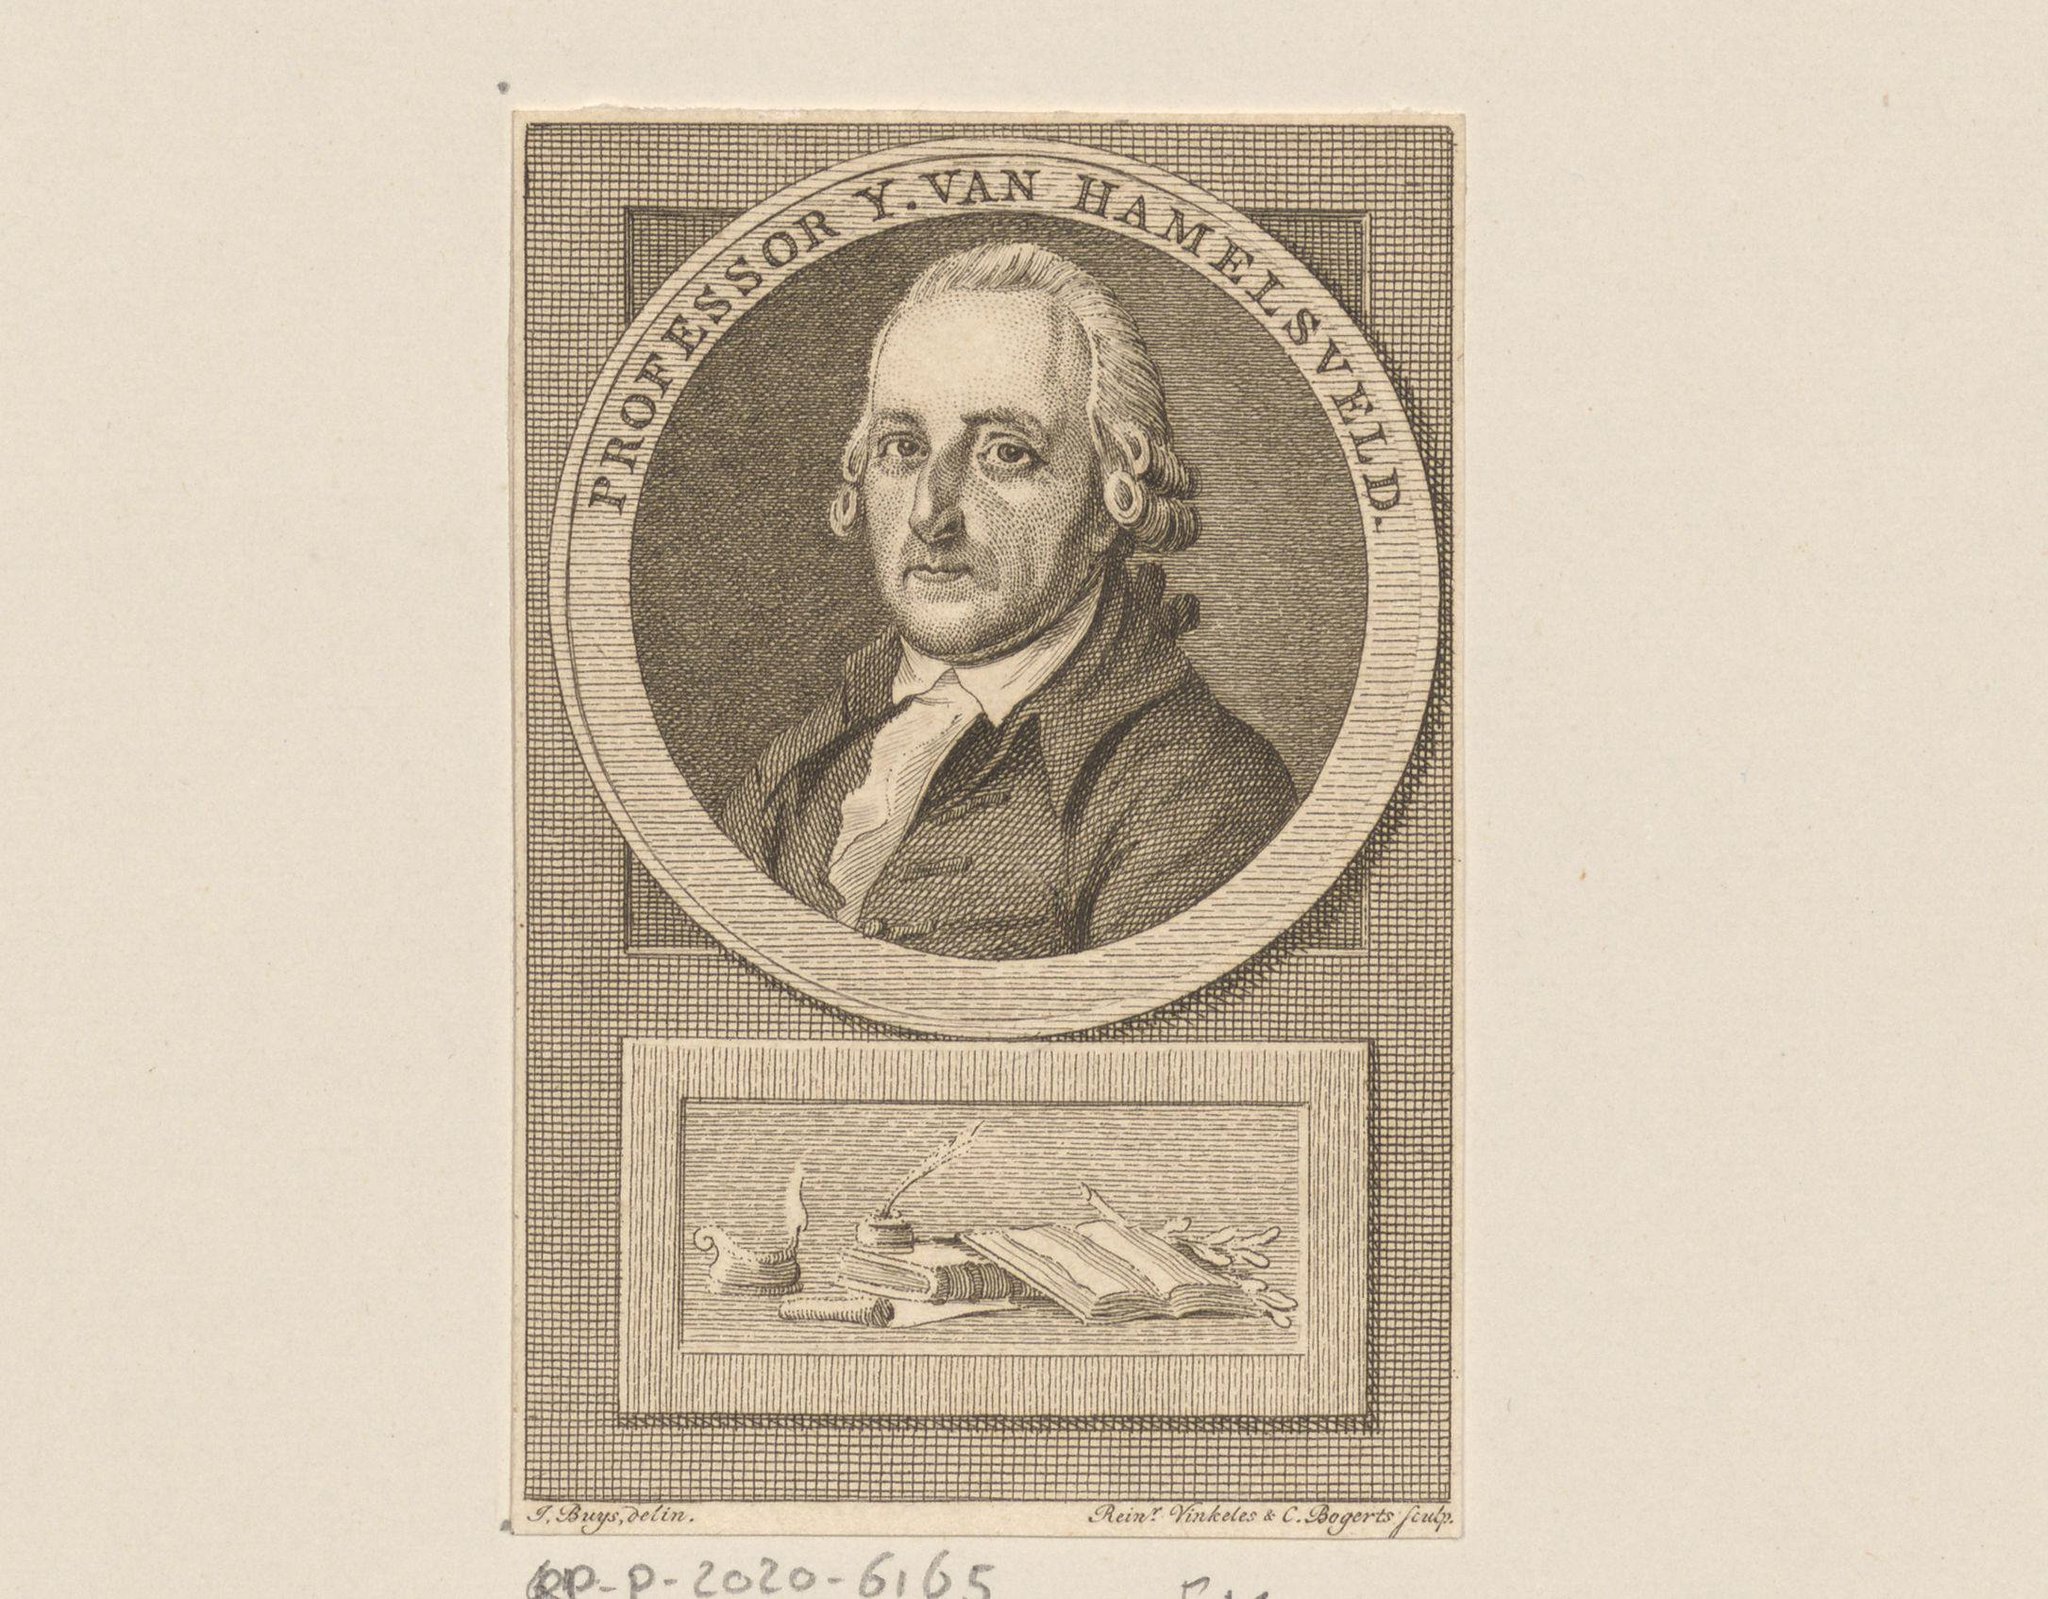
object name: print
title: Portret van IJsbrand van Hamelsveld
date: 1783-1795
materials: paper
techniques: engraving, etching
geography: amsterdam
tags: utrecht, amsterdam, ijsbrand van hamelsveld, historical persons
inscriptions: inscription: ‘Prof: Utrec[...]’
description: Prent uit: Fokke, Jan. Geschiedenissen der Vereenigde Nederlanden voor de vaderlandsche jeugd (...). Amsterdam: Johannes Allart, 1783-1795, dl. 20.